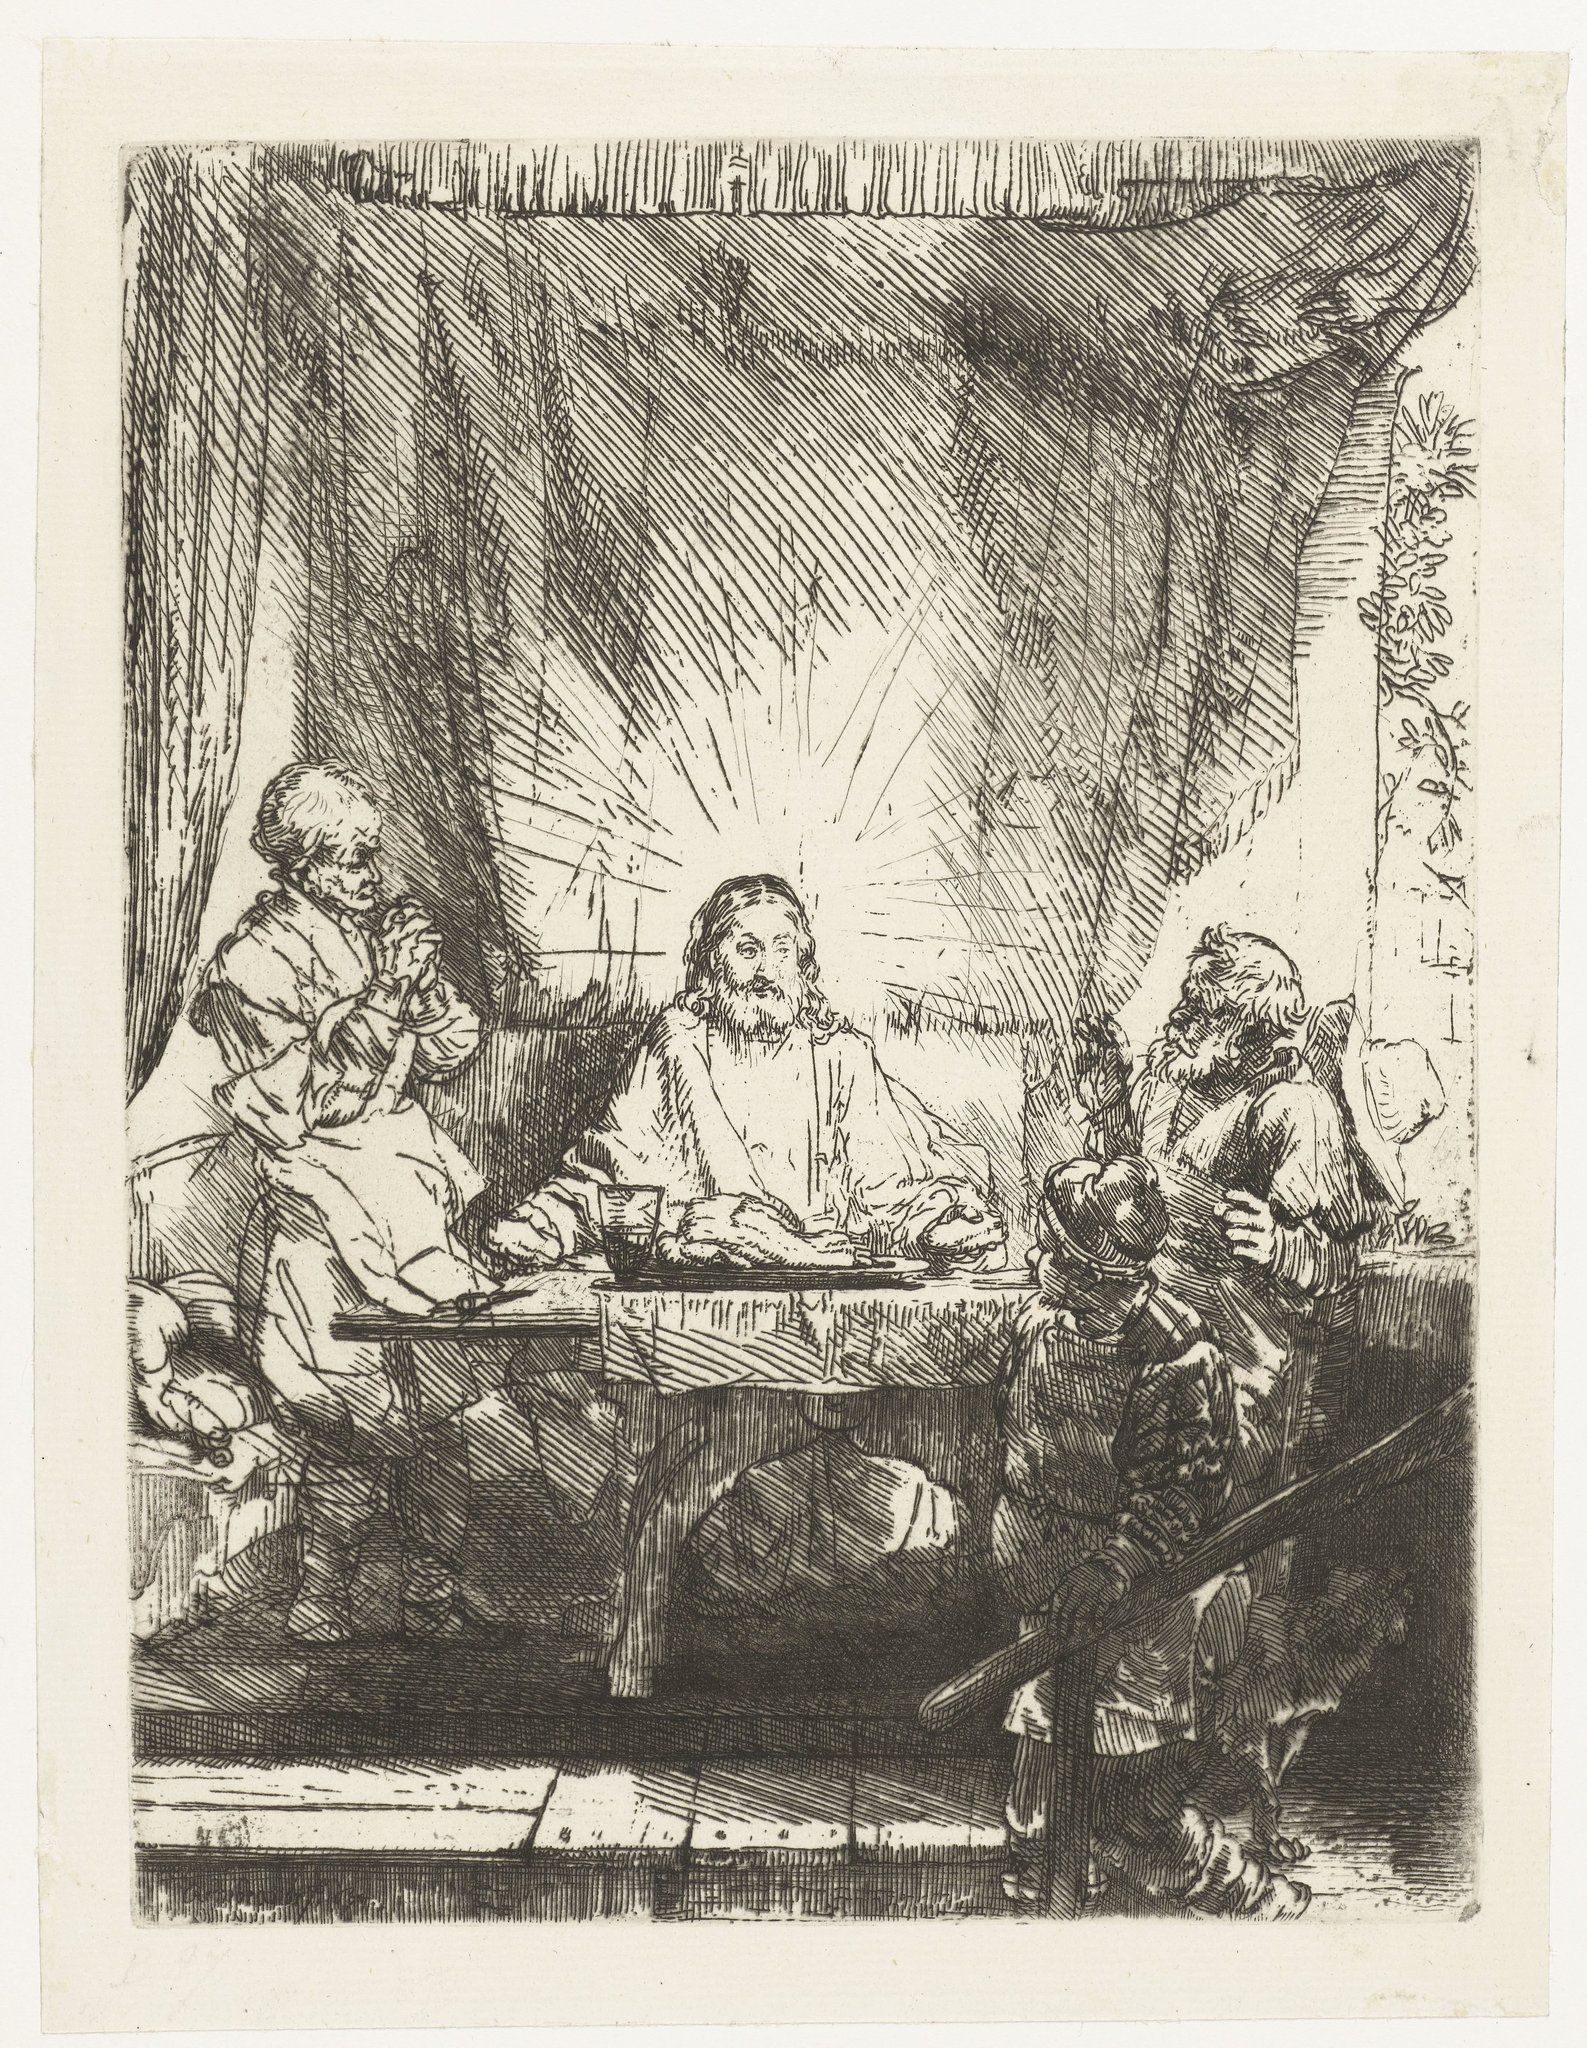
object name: print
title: Christ at Emmaus: the larger plate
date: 1654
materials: paper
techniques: drypoint, etching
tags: the supper at emmaus: christ is recognized while blessing or breaking the bread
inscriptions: inscription: ‘Coppier’, signature and date: ‘Rembrandt f. 1654’